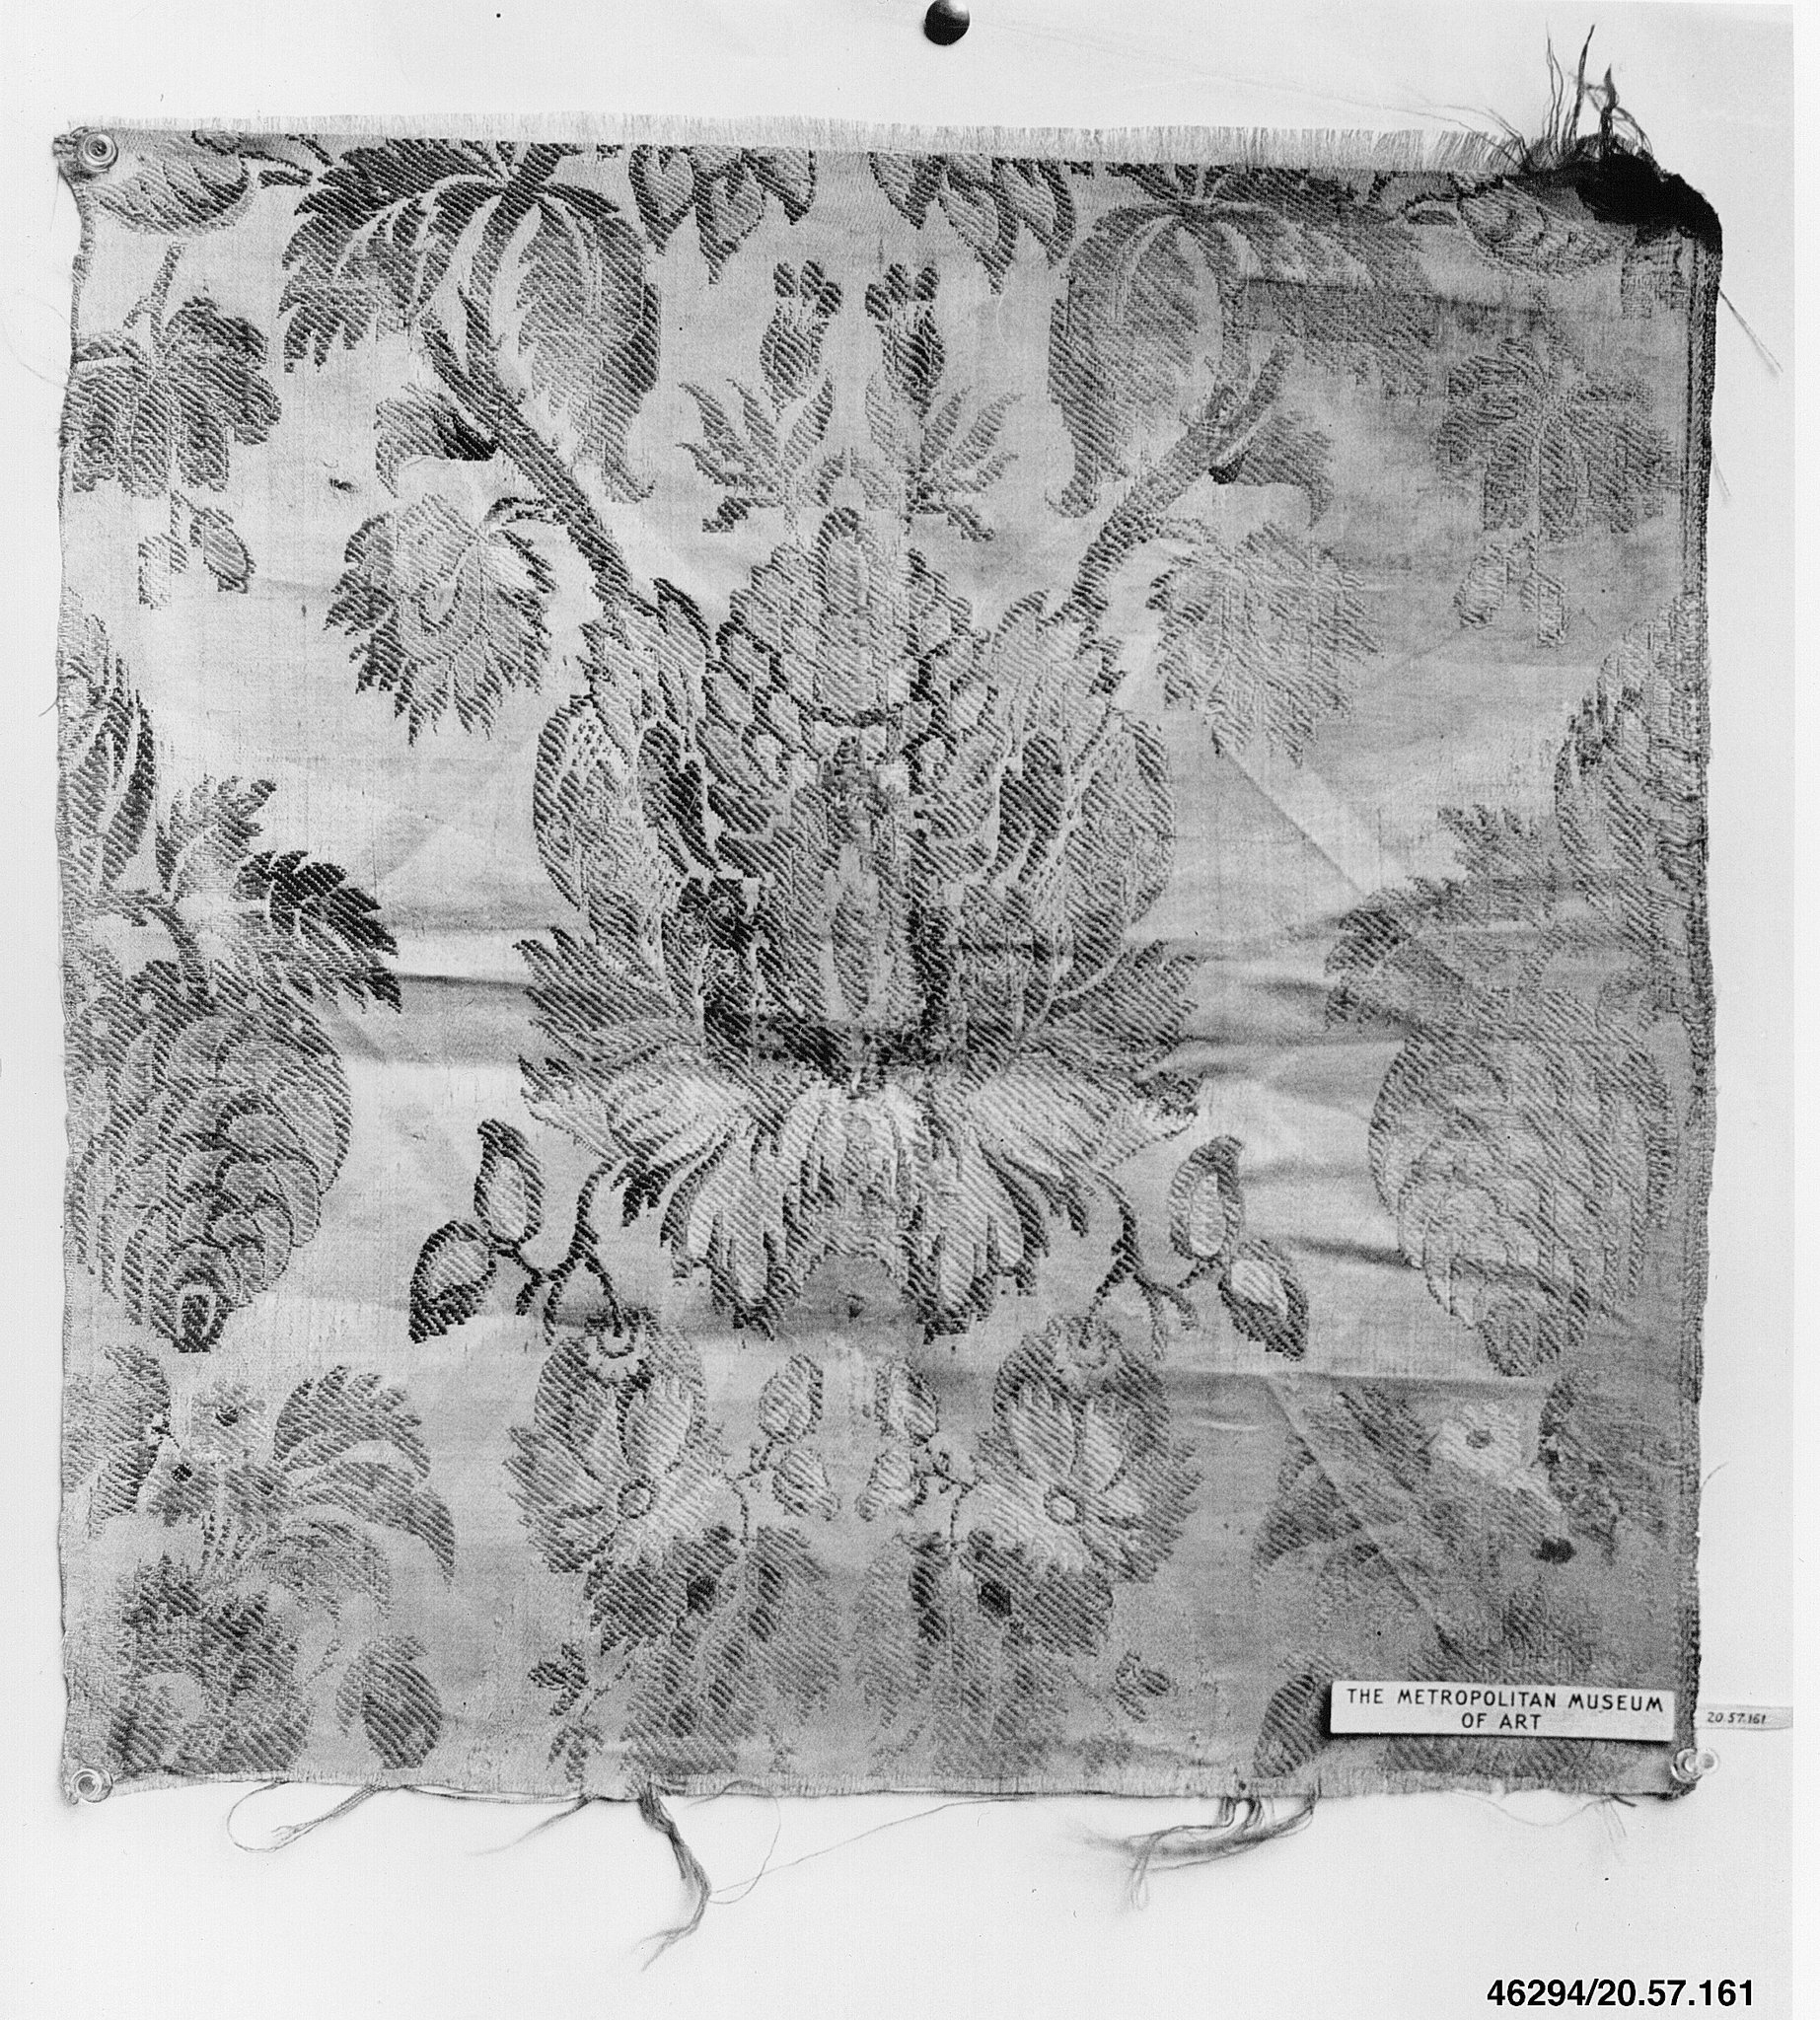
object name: piece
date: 1730-1735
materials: silk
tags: flowers,leaves